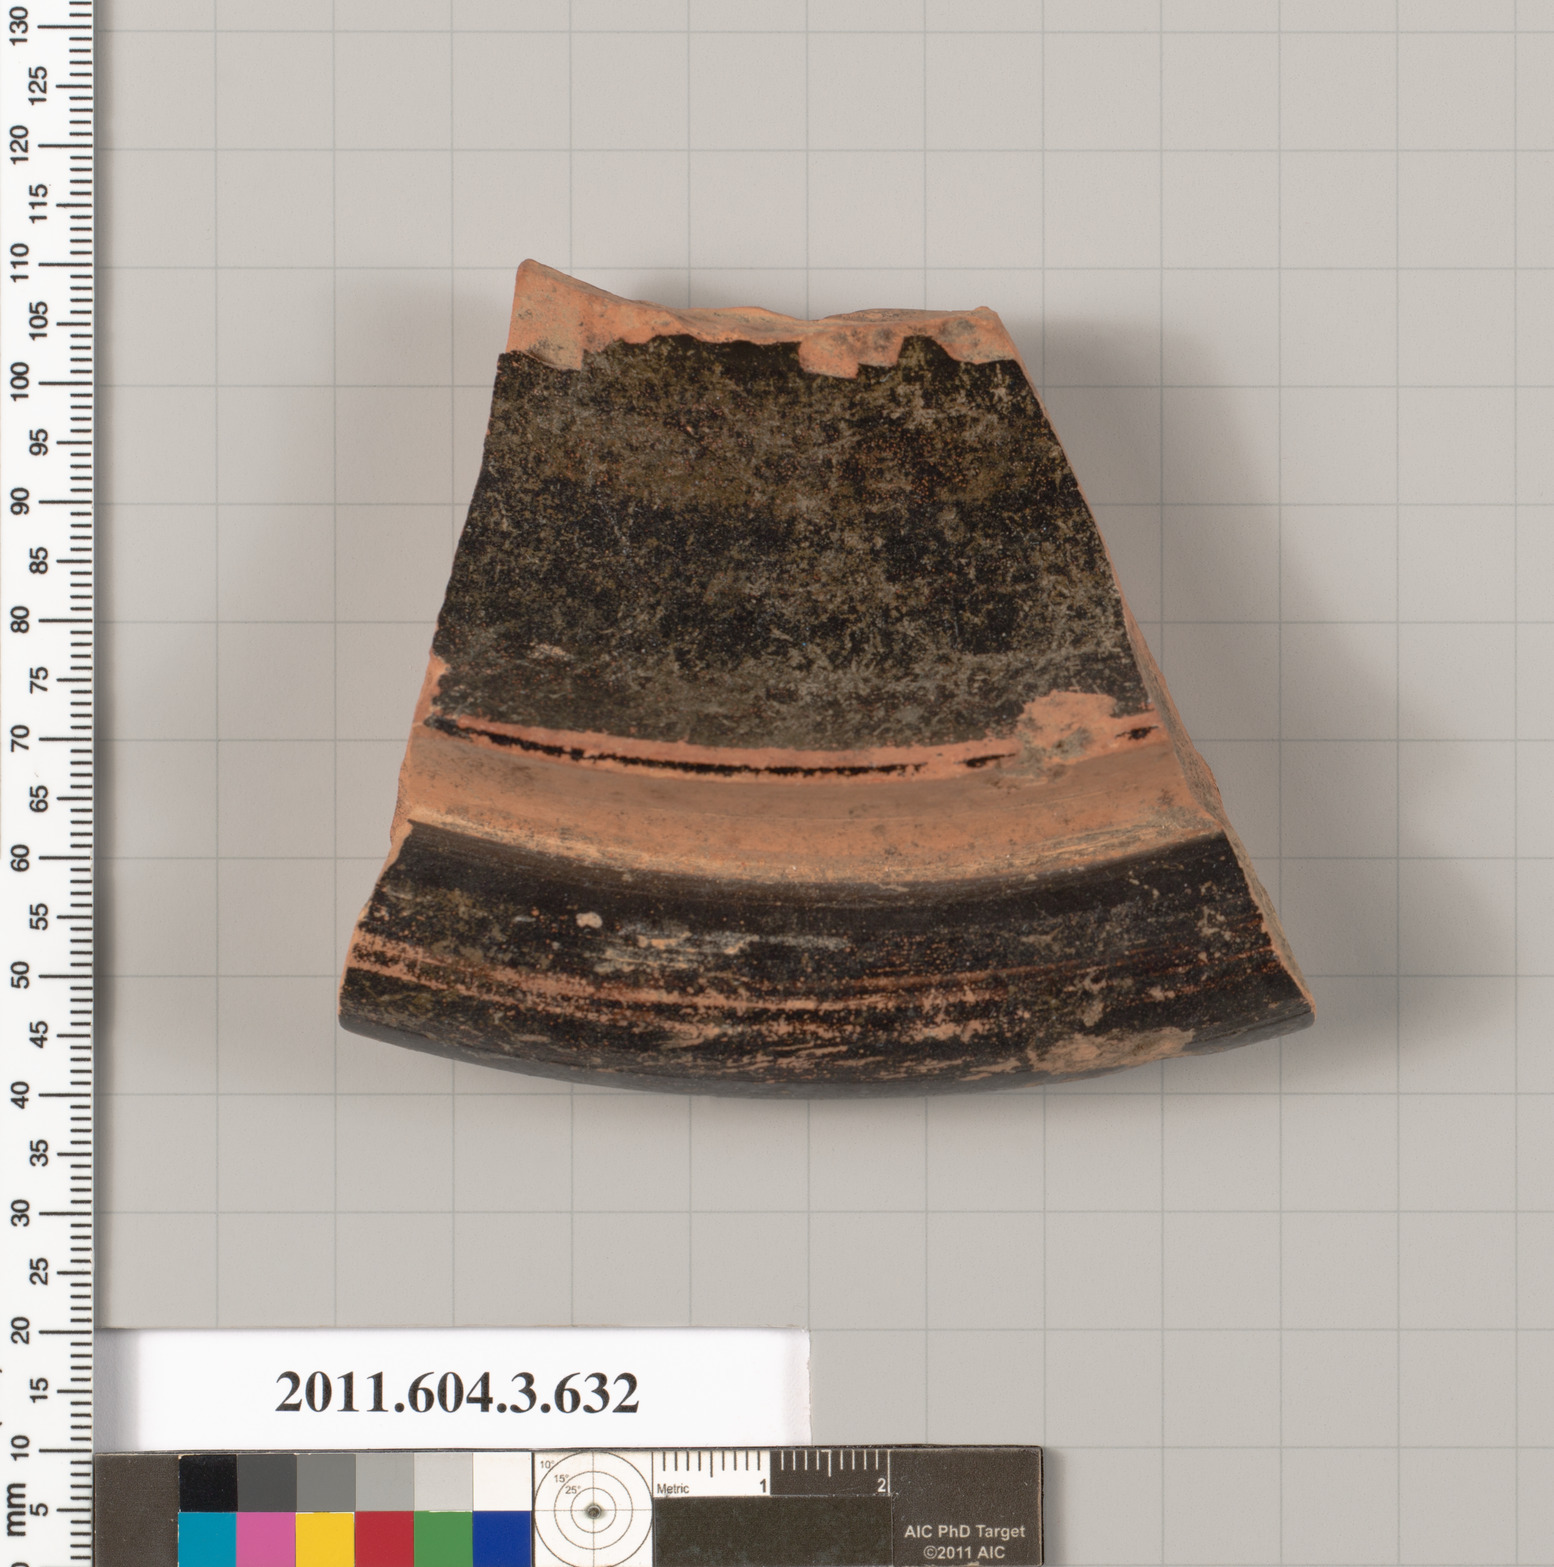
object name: calyx krater fragment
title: Terracotta fragment of a calyx-krater (bowl for mixing wine and water)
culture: greek, attic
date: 600-401 BCE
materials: terracotta